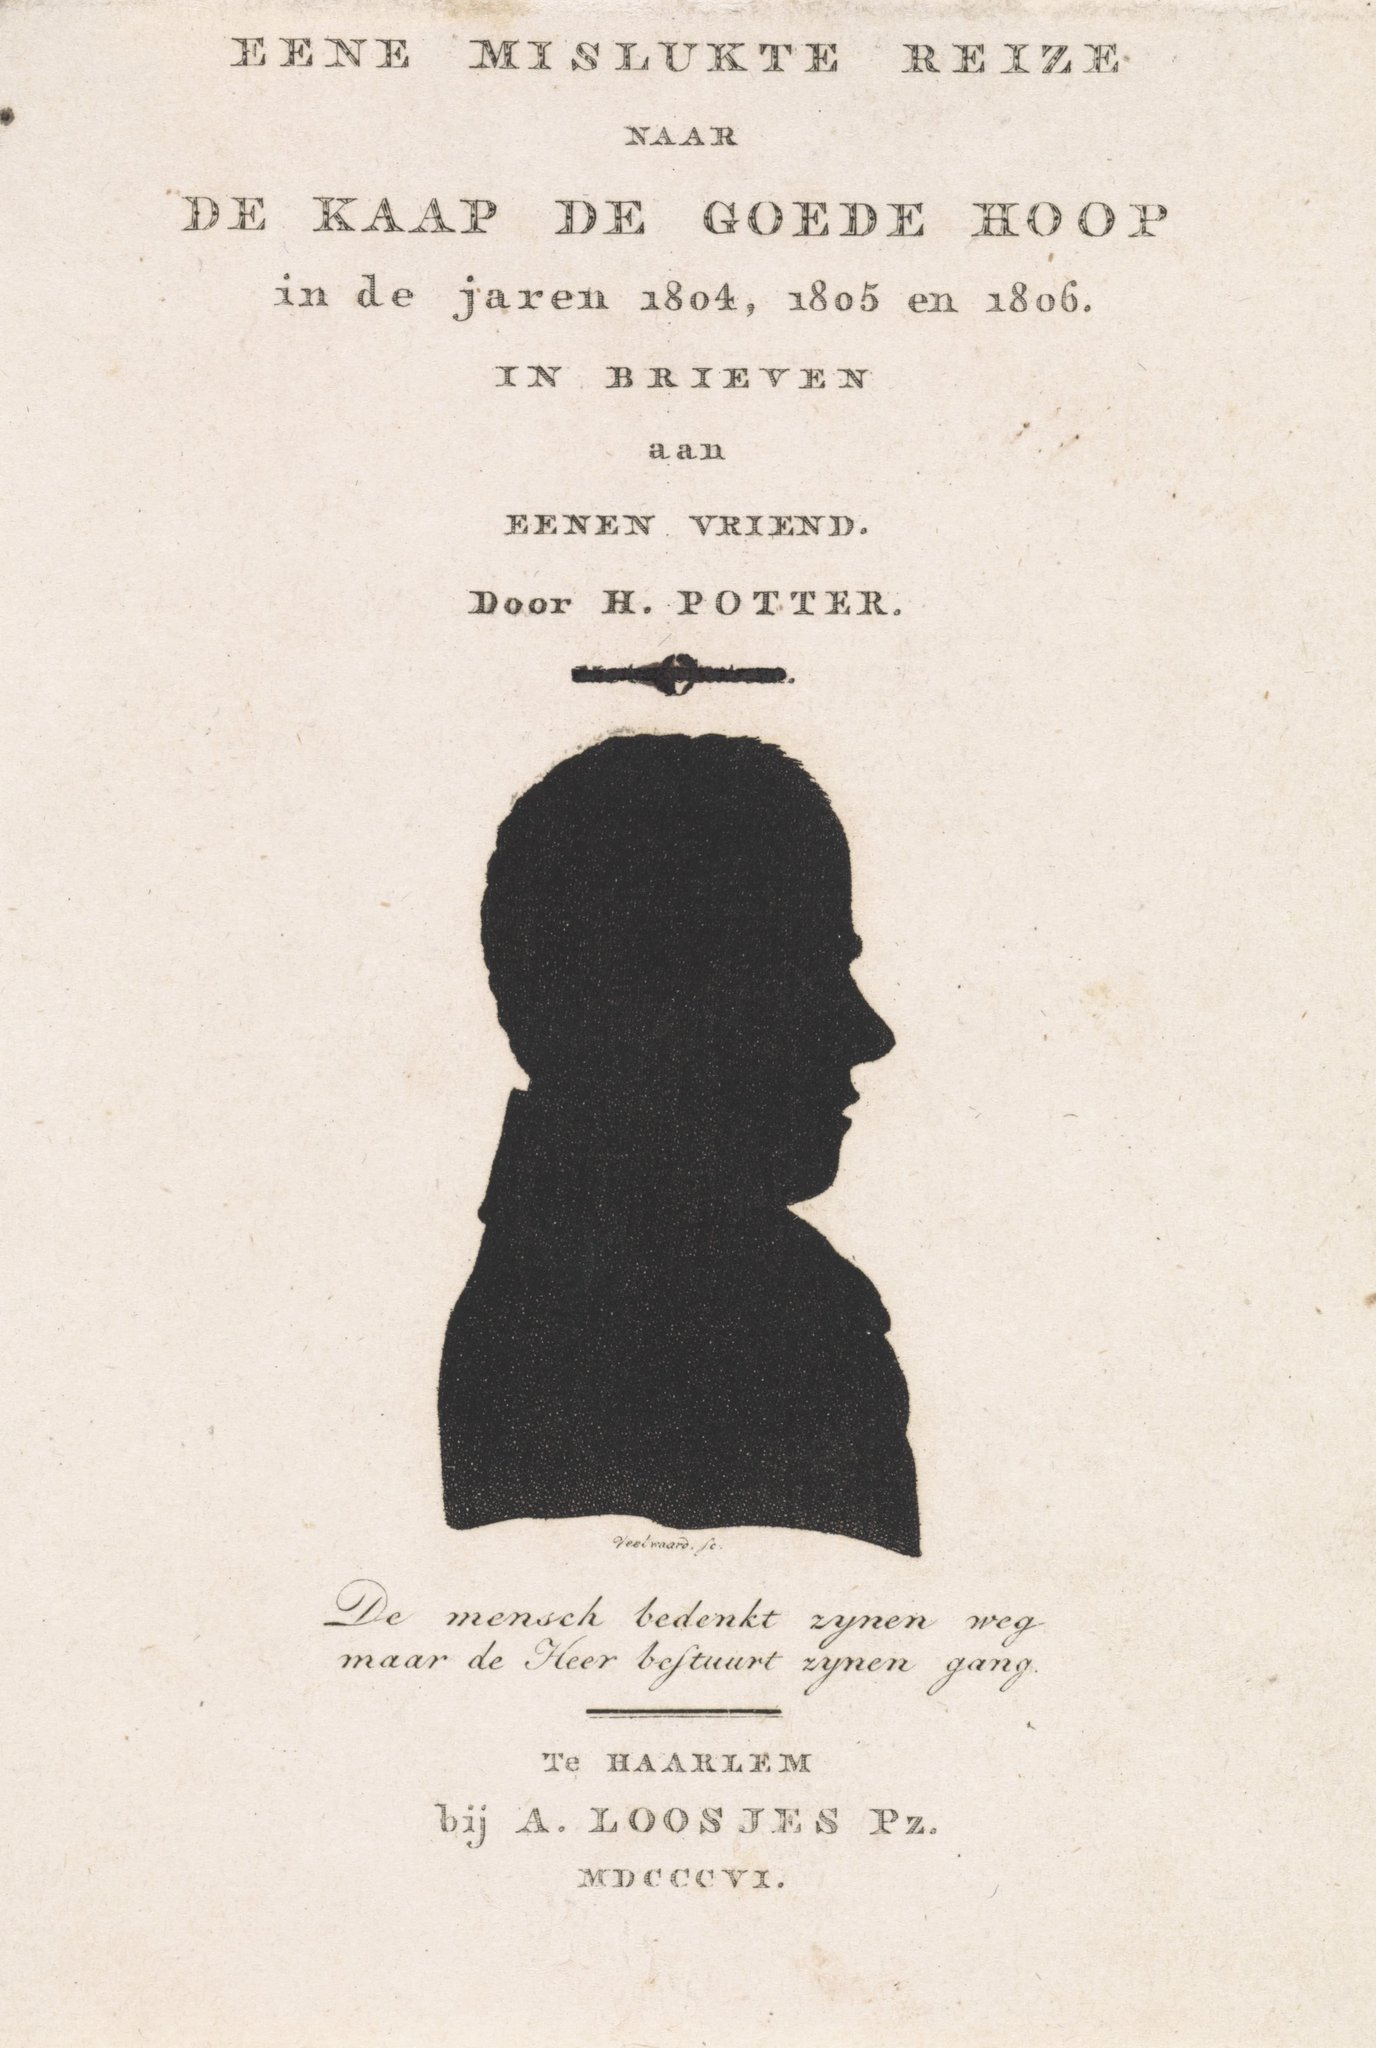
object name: print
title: Silhouetportret van de schrijver Heabele Potter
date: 1806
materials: paper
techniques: etching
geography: haarlem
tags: surabaya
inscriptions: collector's mark: Lugt 2228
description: Titelpagina voor: Potter, Heabele. Lotgevallen en ontmoetingen op eene mislukte reize naar de Kaap de Goede Hoop in de jaren 1804, 1805 en 1806. In brieven aan eenen vriend. Haarlem: Weduwe Adriaan